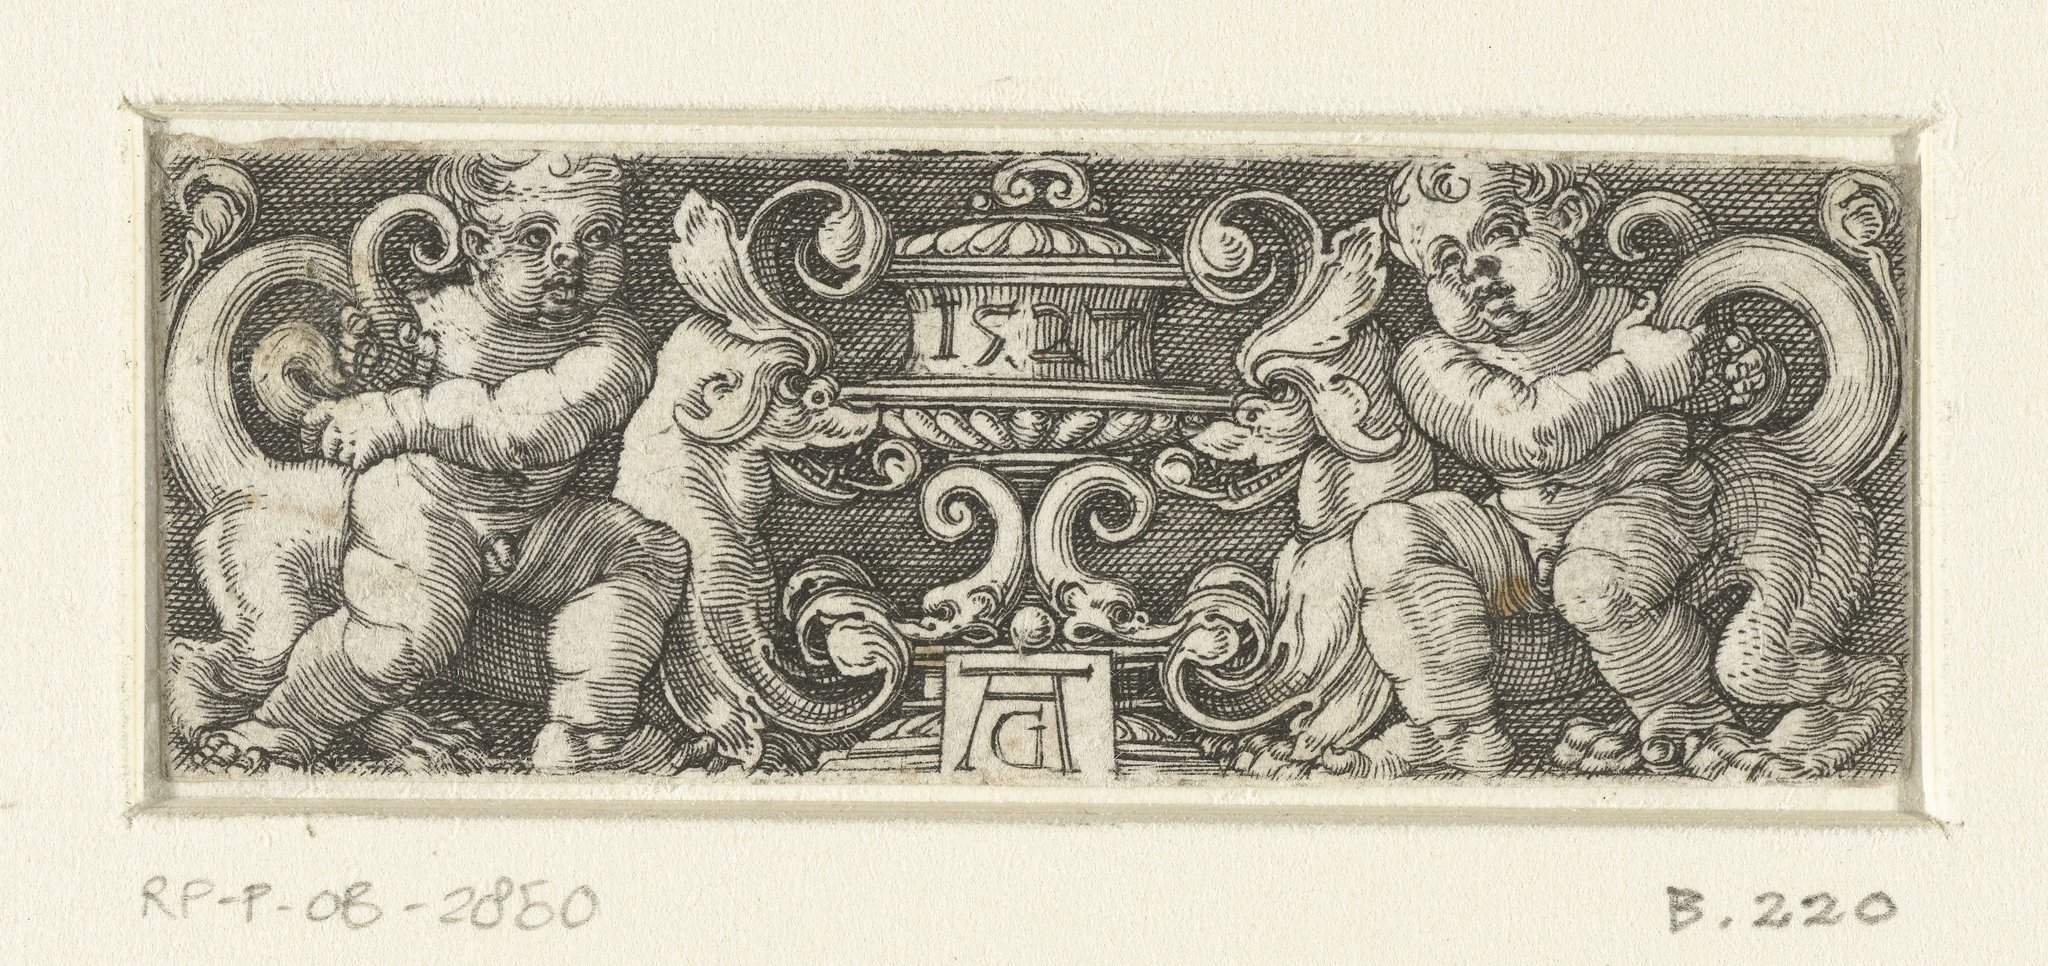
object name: ornament print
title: Fries met een vaas en twee jongetjes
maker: heinrich aldegrever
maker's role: draughtsman, print maker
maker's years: 1502-1561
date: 1527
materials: paper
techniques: engraving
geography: germany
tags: ornament ~ hybrid animals, vase ~ ornament, child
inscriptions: number: ‘12’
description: Fries met een vaas tussen twee fantasiedieren. Op elk dier rijdt een naakt jongetje.